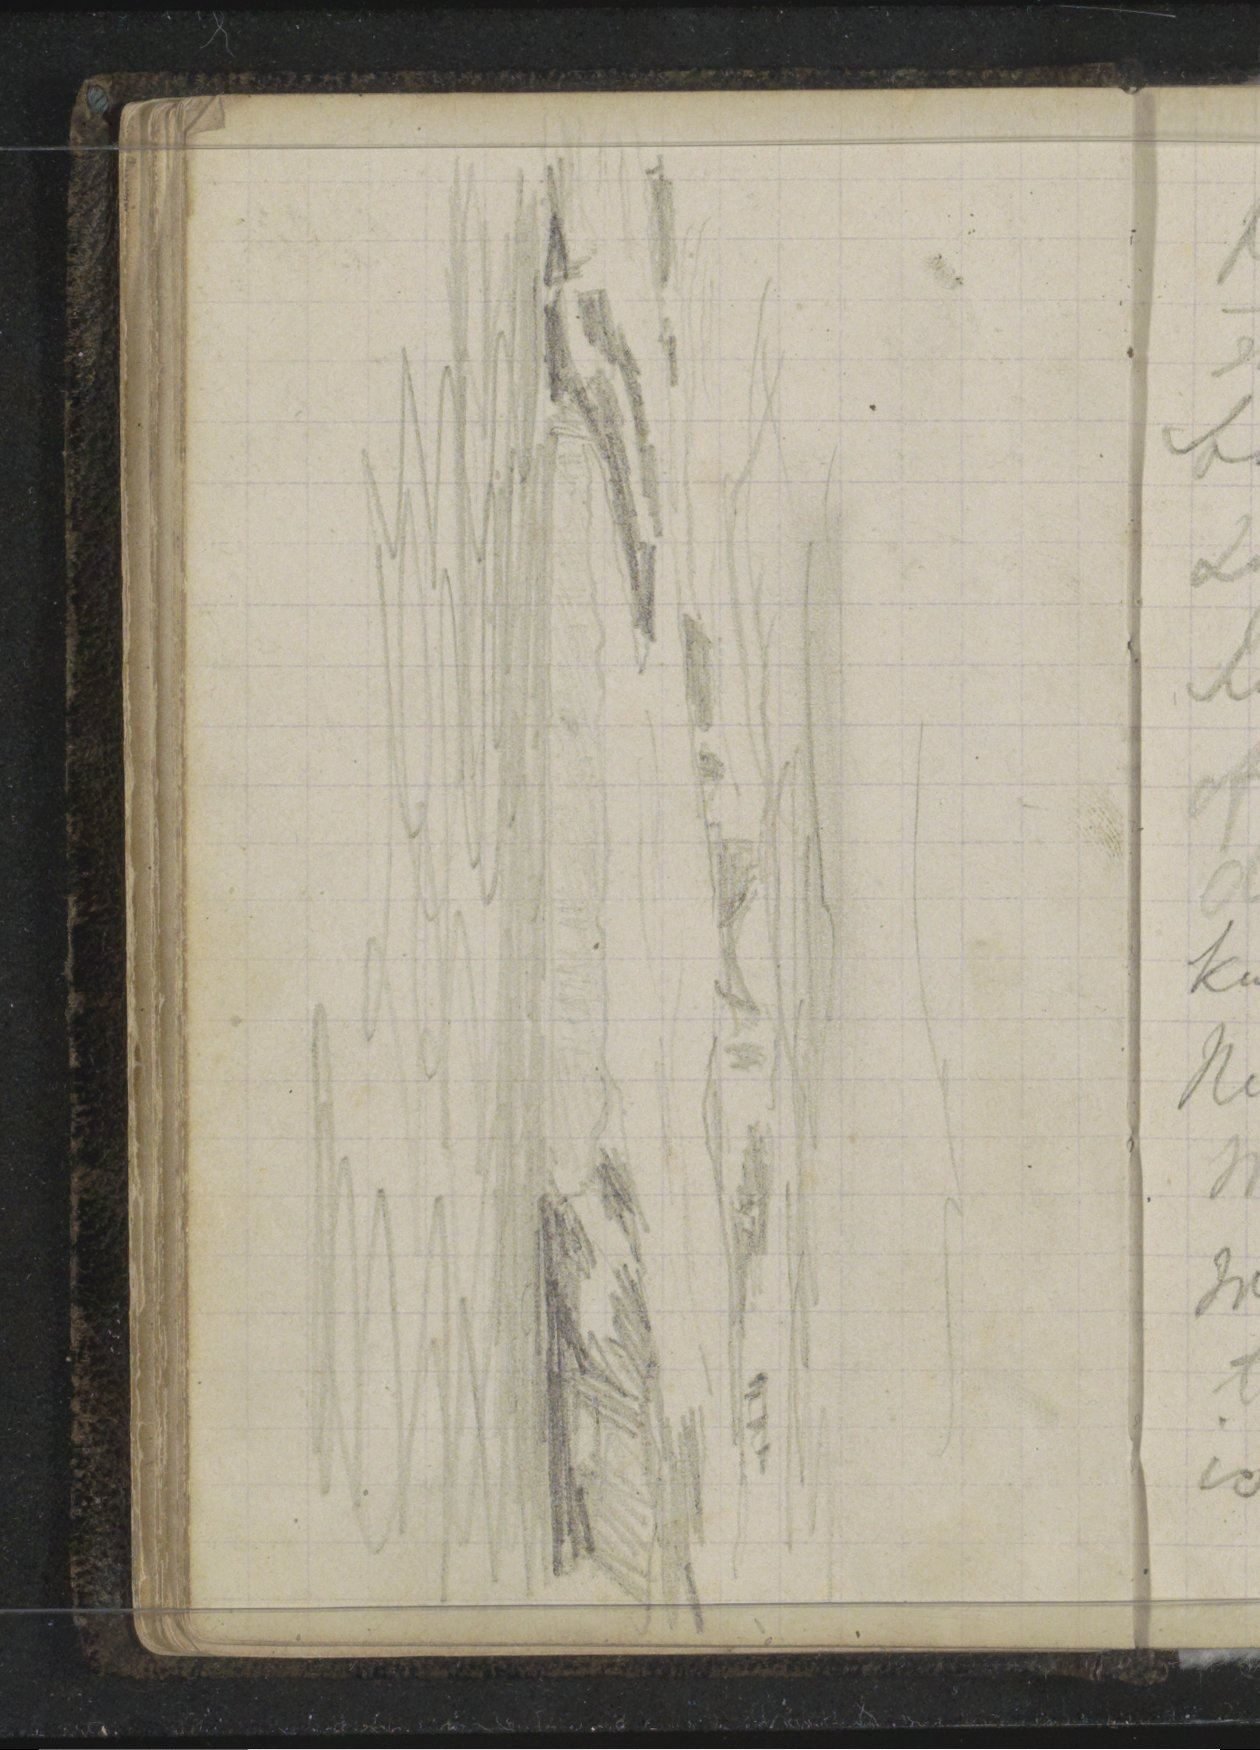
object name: sketchbook leaf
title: Gezicht op een ijsschots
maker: louis apol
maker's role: draughtsman, painter, print maker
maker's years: 1850-1936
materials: pencil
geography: barentsz sea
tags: island (in polar regions)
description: Mogelijk met een kleine nederzetting. Blad 26 verso uit een schetsboek met 110 bladen betekend tijdens de expeditie naar Nova Zembla in 1880.